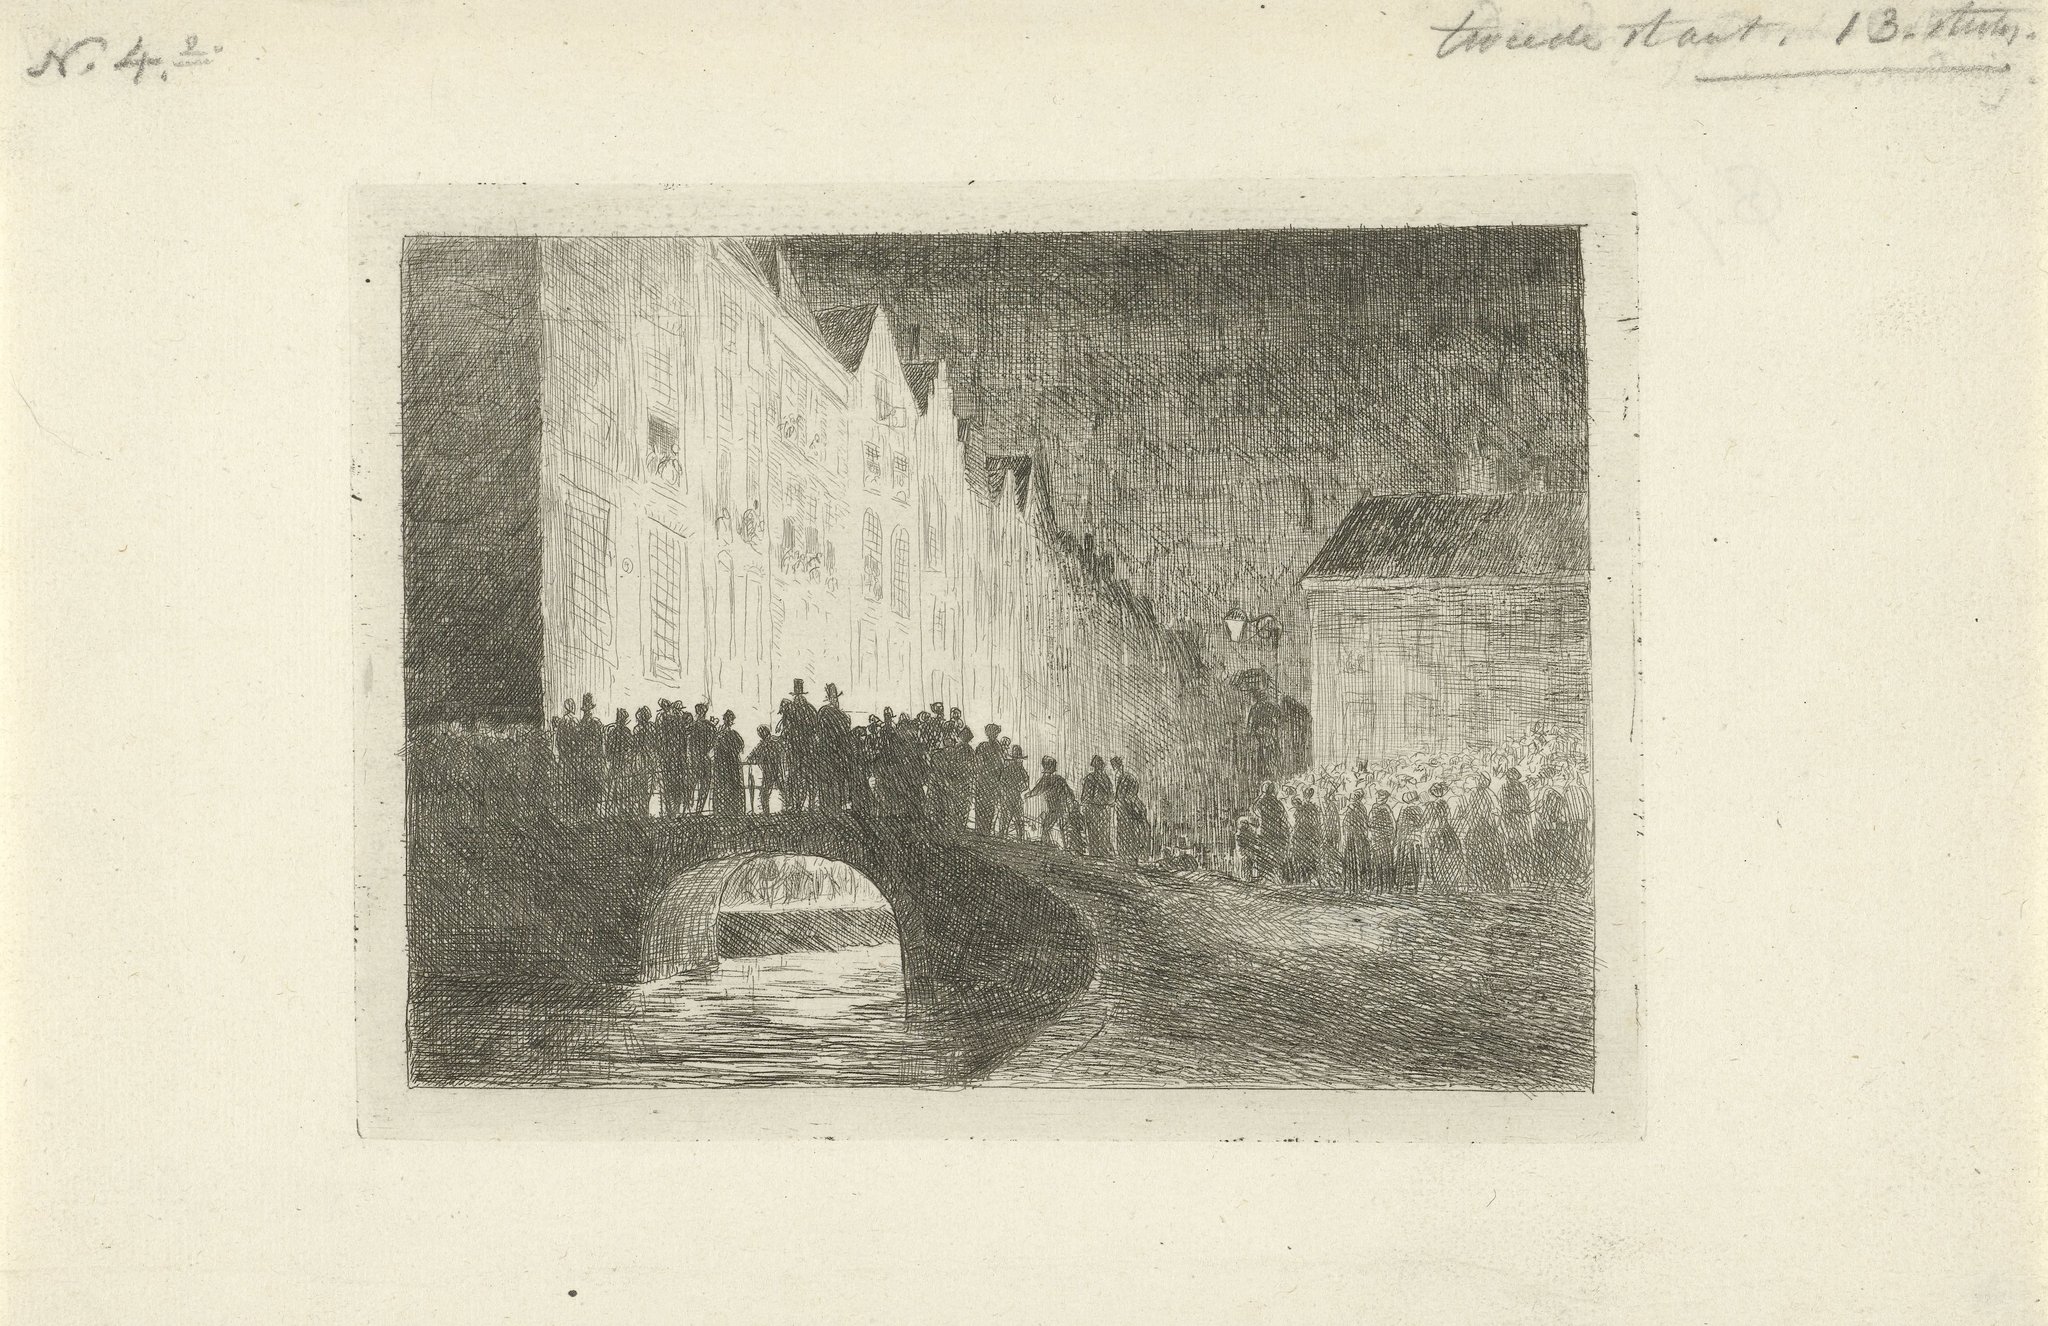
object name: print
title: Serenade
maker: cornelis van der griendt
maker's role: draughtsman, painter, print maker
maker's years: 1827-1918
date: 1852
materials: paper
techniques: etching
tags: city-view in general; 'veduta' (+ city(-scape) with figures, staffage)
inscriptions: collector's mark: Lugt 2228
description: Nachtelijk stadsgezicht met een zanger en toeschouwers.